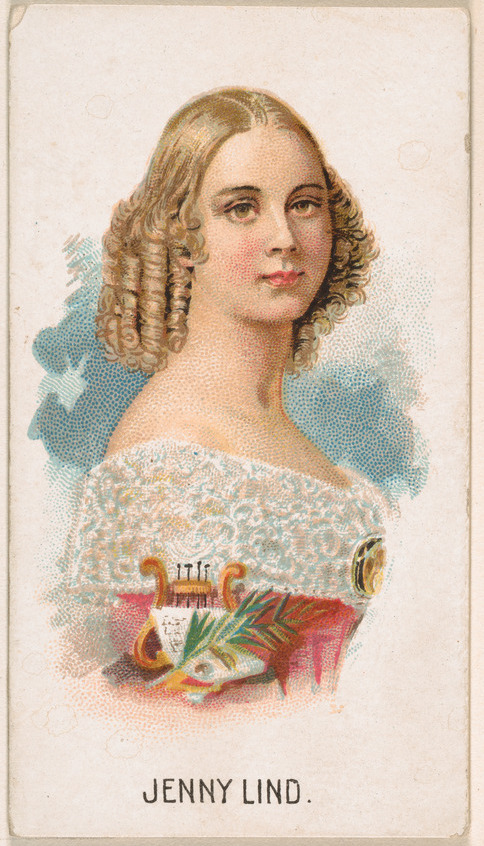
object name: print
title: Jenny Lind, from Leaders series (N222) issued by Kinney Bros.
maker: kinney brothers tobacco company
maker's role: publisher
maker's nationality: american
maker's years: 1869-2011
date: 1888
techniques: color lithograph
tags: women,singers